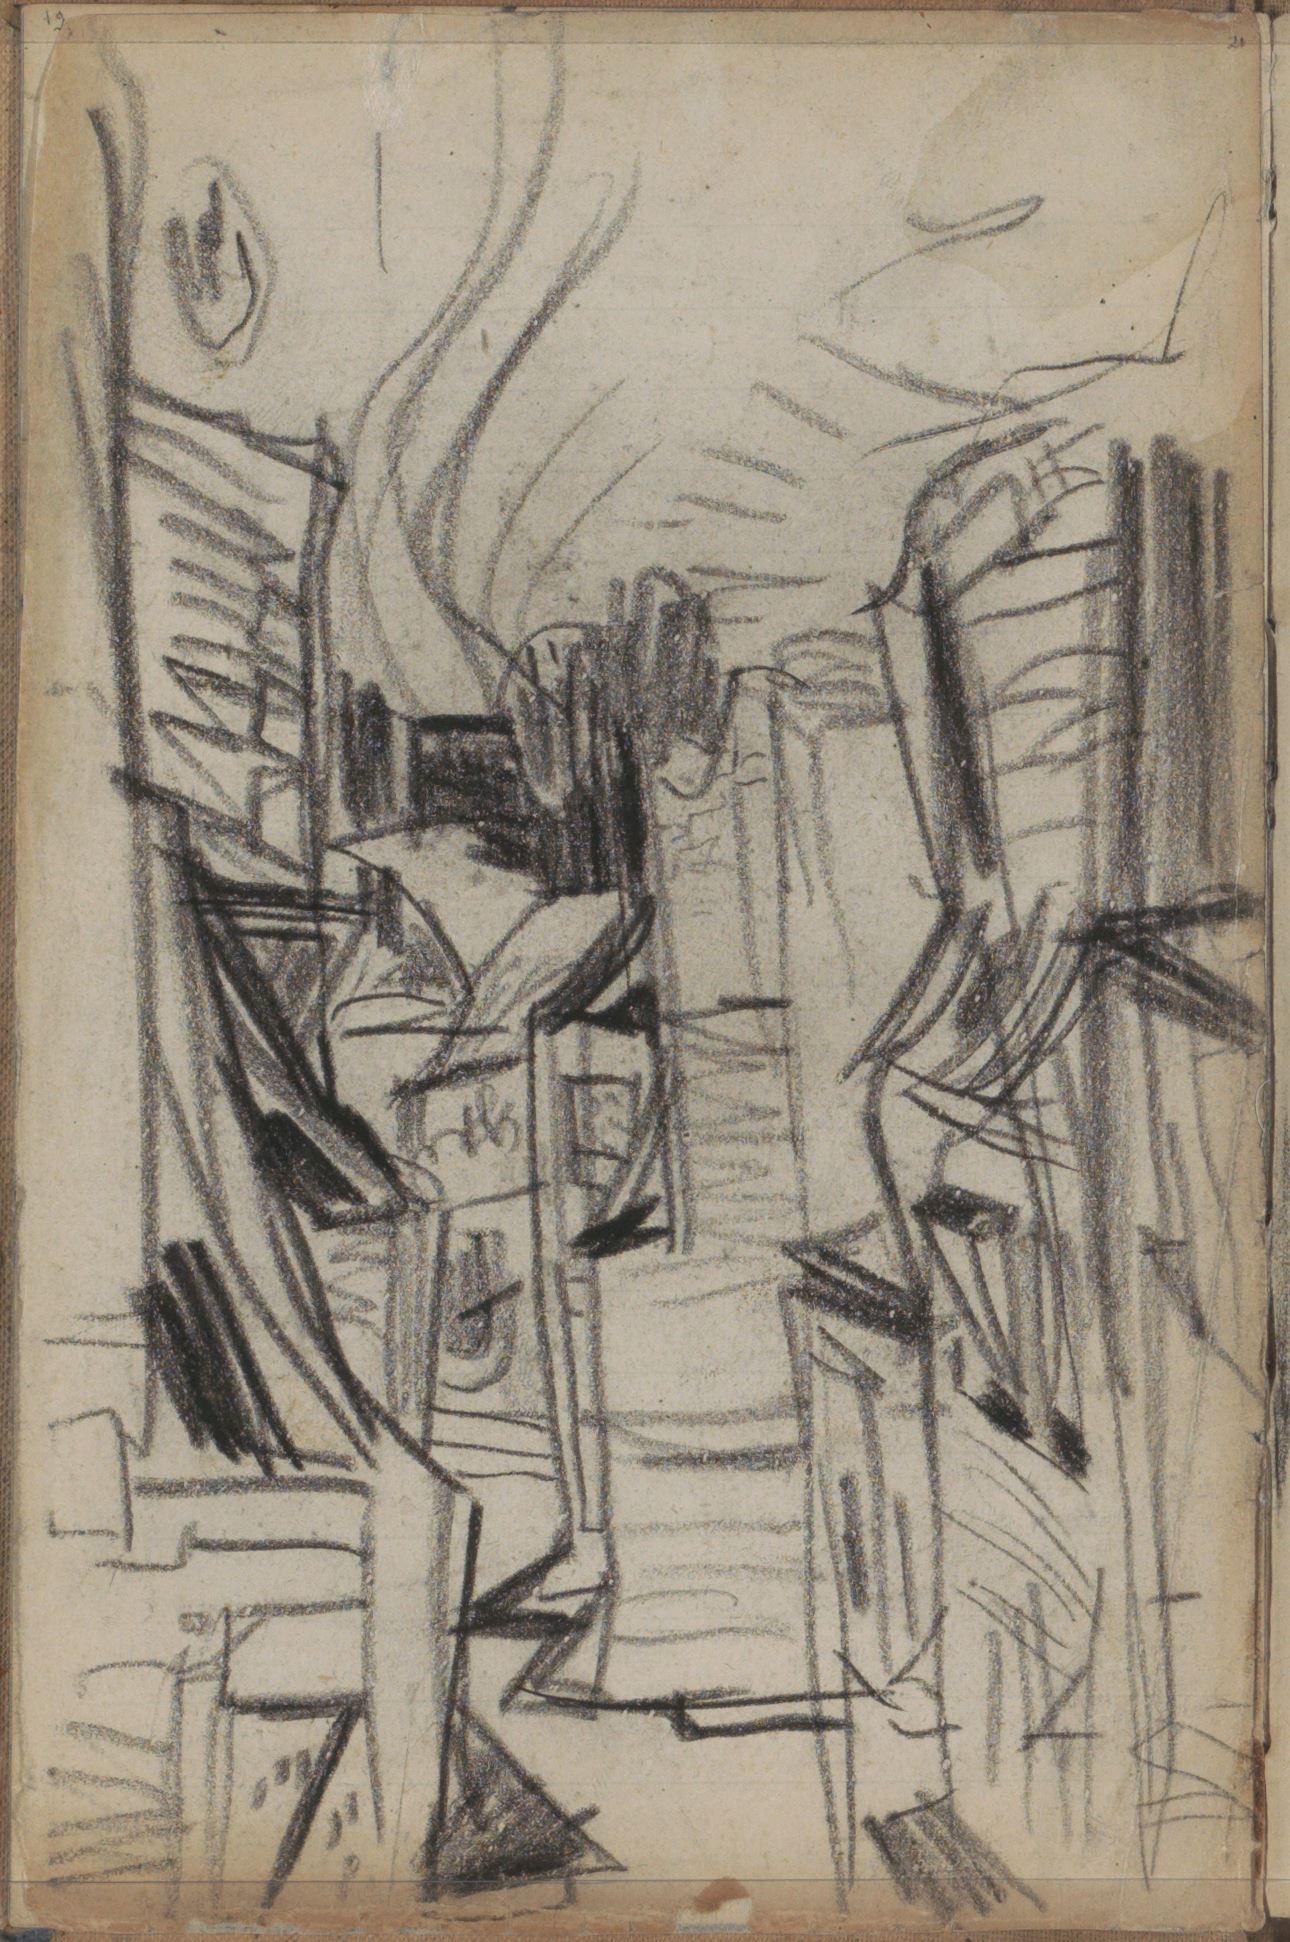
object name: sketchbook leaf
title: Figuur in een straat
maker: marius bauer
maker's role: draughtsman, print maker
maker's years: 1867-1932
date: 1888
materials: chalk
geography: istanbul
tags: street (+ city(-scape) with figures, staffage)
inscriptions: kleurnotitie, handgeschreven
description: Pagina 21 uit een schetsboek met 58 bladen.